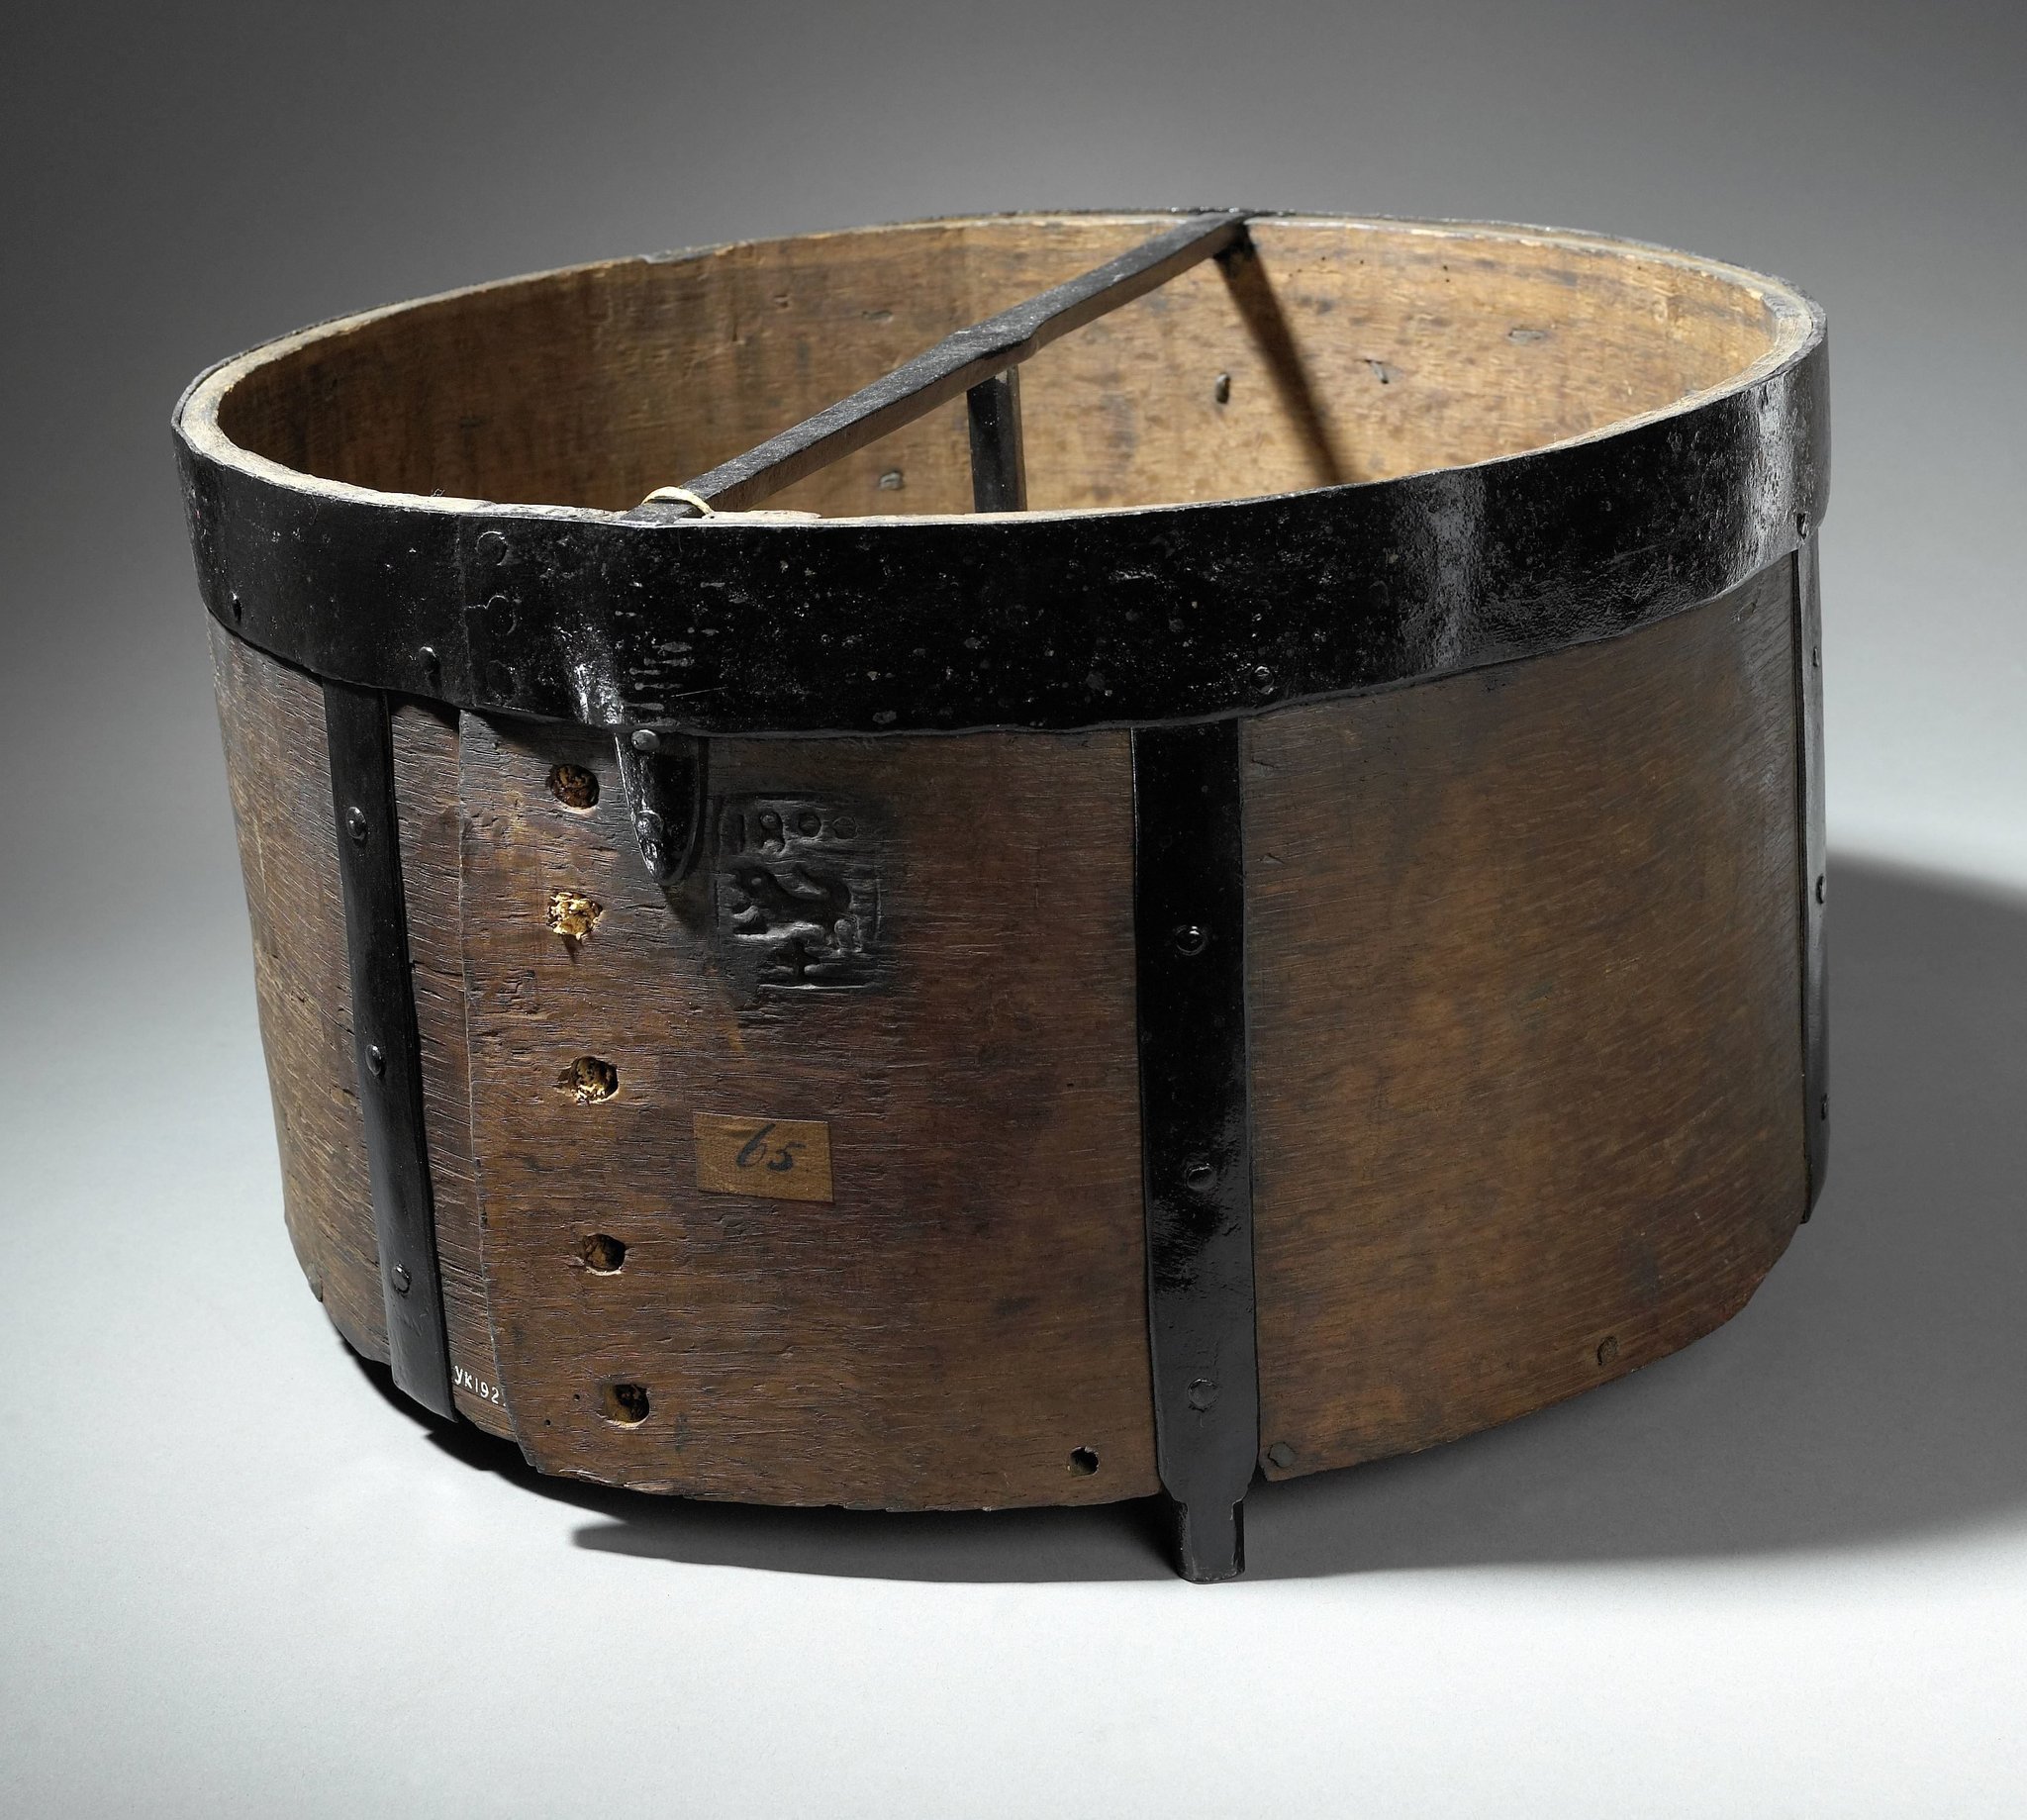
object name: inhoudsmaat droge waren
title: Een Boisseau uit Zutphen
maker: Anonymous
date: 1800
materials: wood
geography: zutphen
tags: zutphen (stad)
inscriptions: : ‘1800’, title: ‘Zutphen / 1 schepel’, title: ‘de Zutphen un Boisse’, number: ‘65’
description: Spanen inhoudsmaat met ijzeren beslag voor droge waren van 1 Boisseau met brug en stijl, v.z.v. merk, label aan een lintje en etiketten.